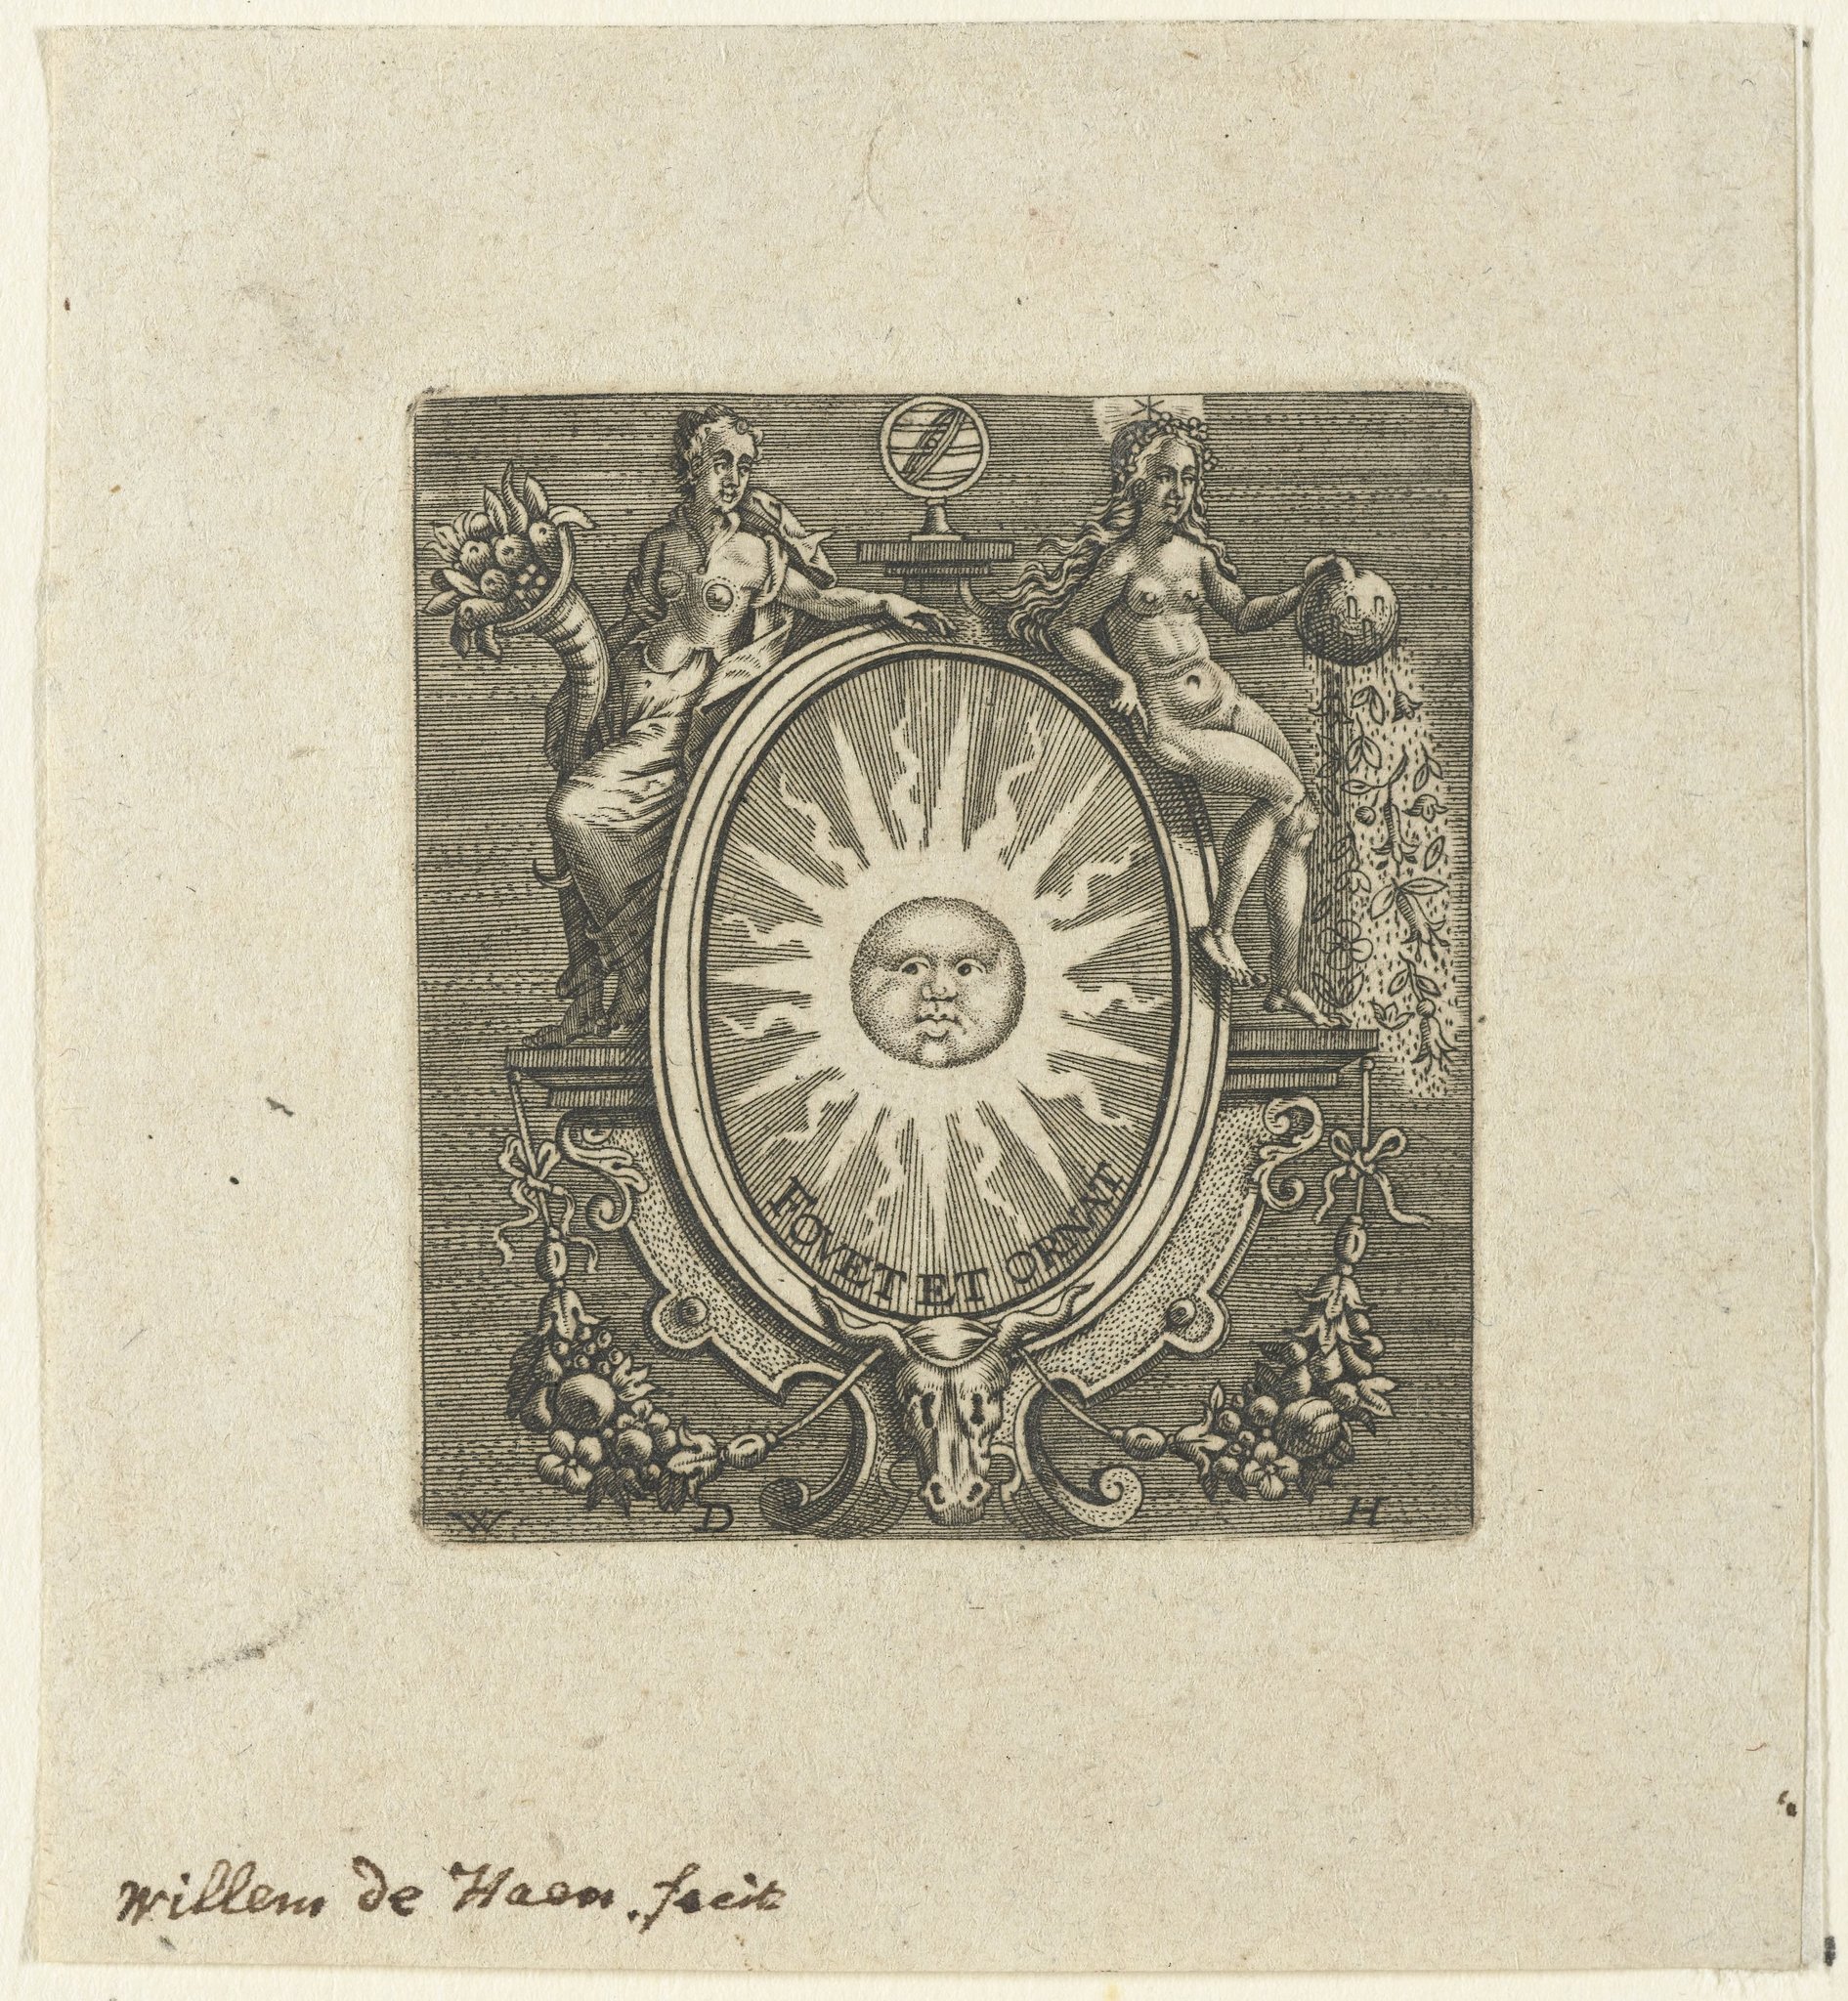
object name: print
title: Fovet et Ornat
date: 1615-1620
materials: paper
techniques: engraving, etching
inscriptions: inscription: ‘Willem de Haen. fecit.’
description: Het medaillon wordt geflankeerd door twee vrouwen. De vrouw links heeft een hoorn des overvloeds vast.